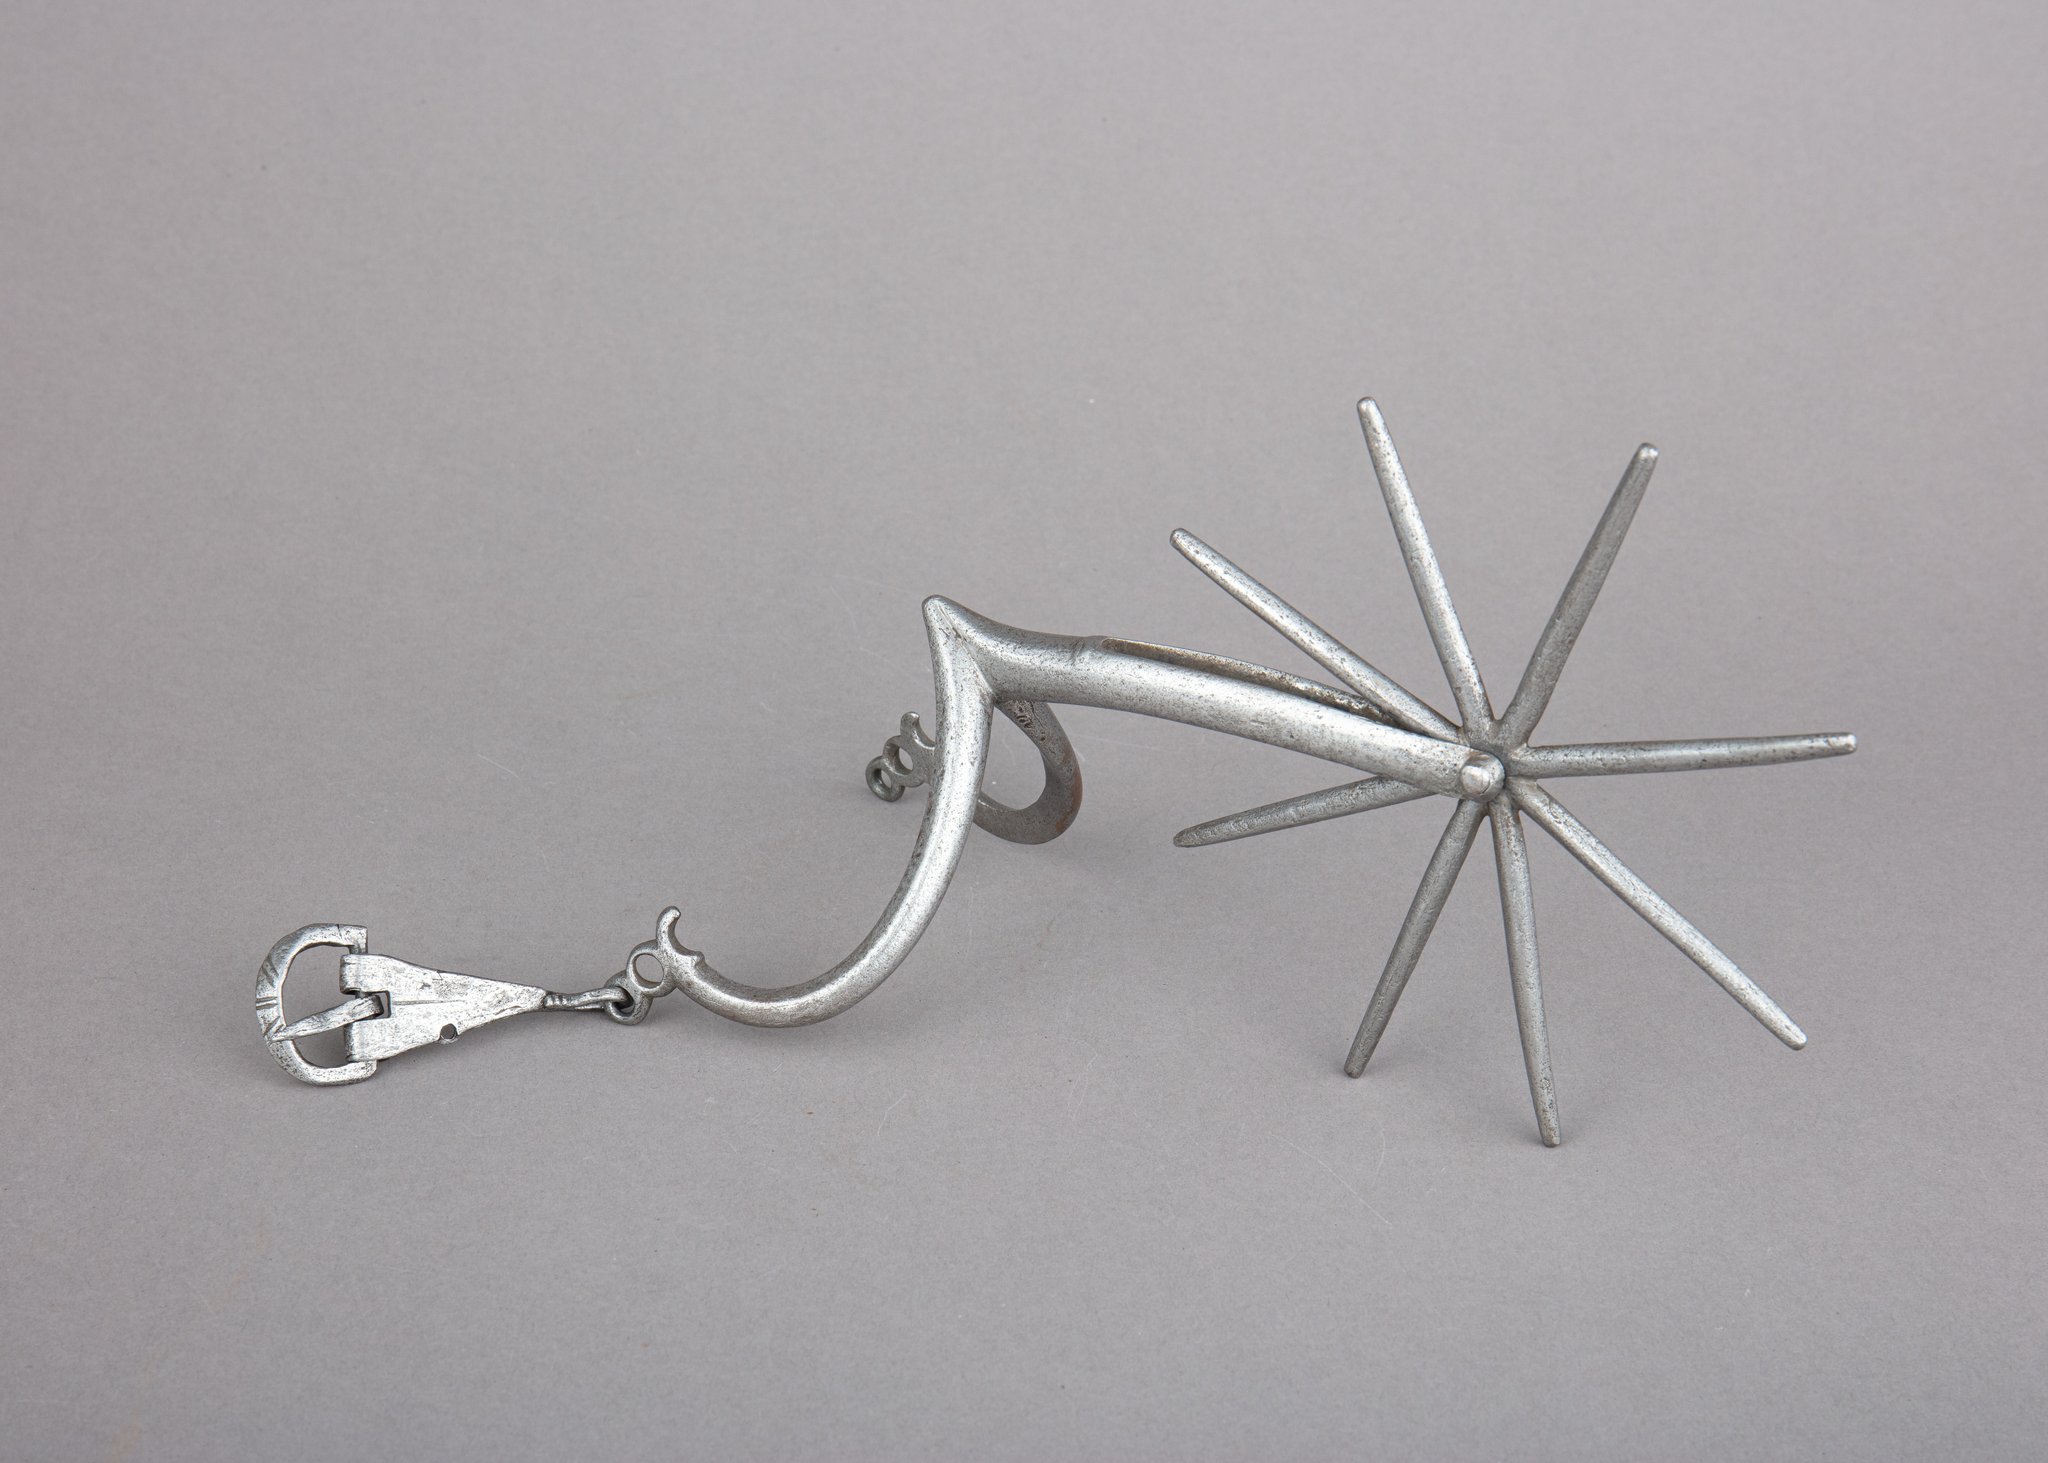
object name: spur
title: Rowel Spur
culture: hungarian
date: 1501-1600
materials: metal alloy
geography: hungary